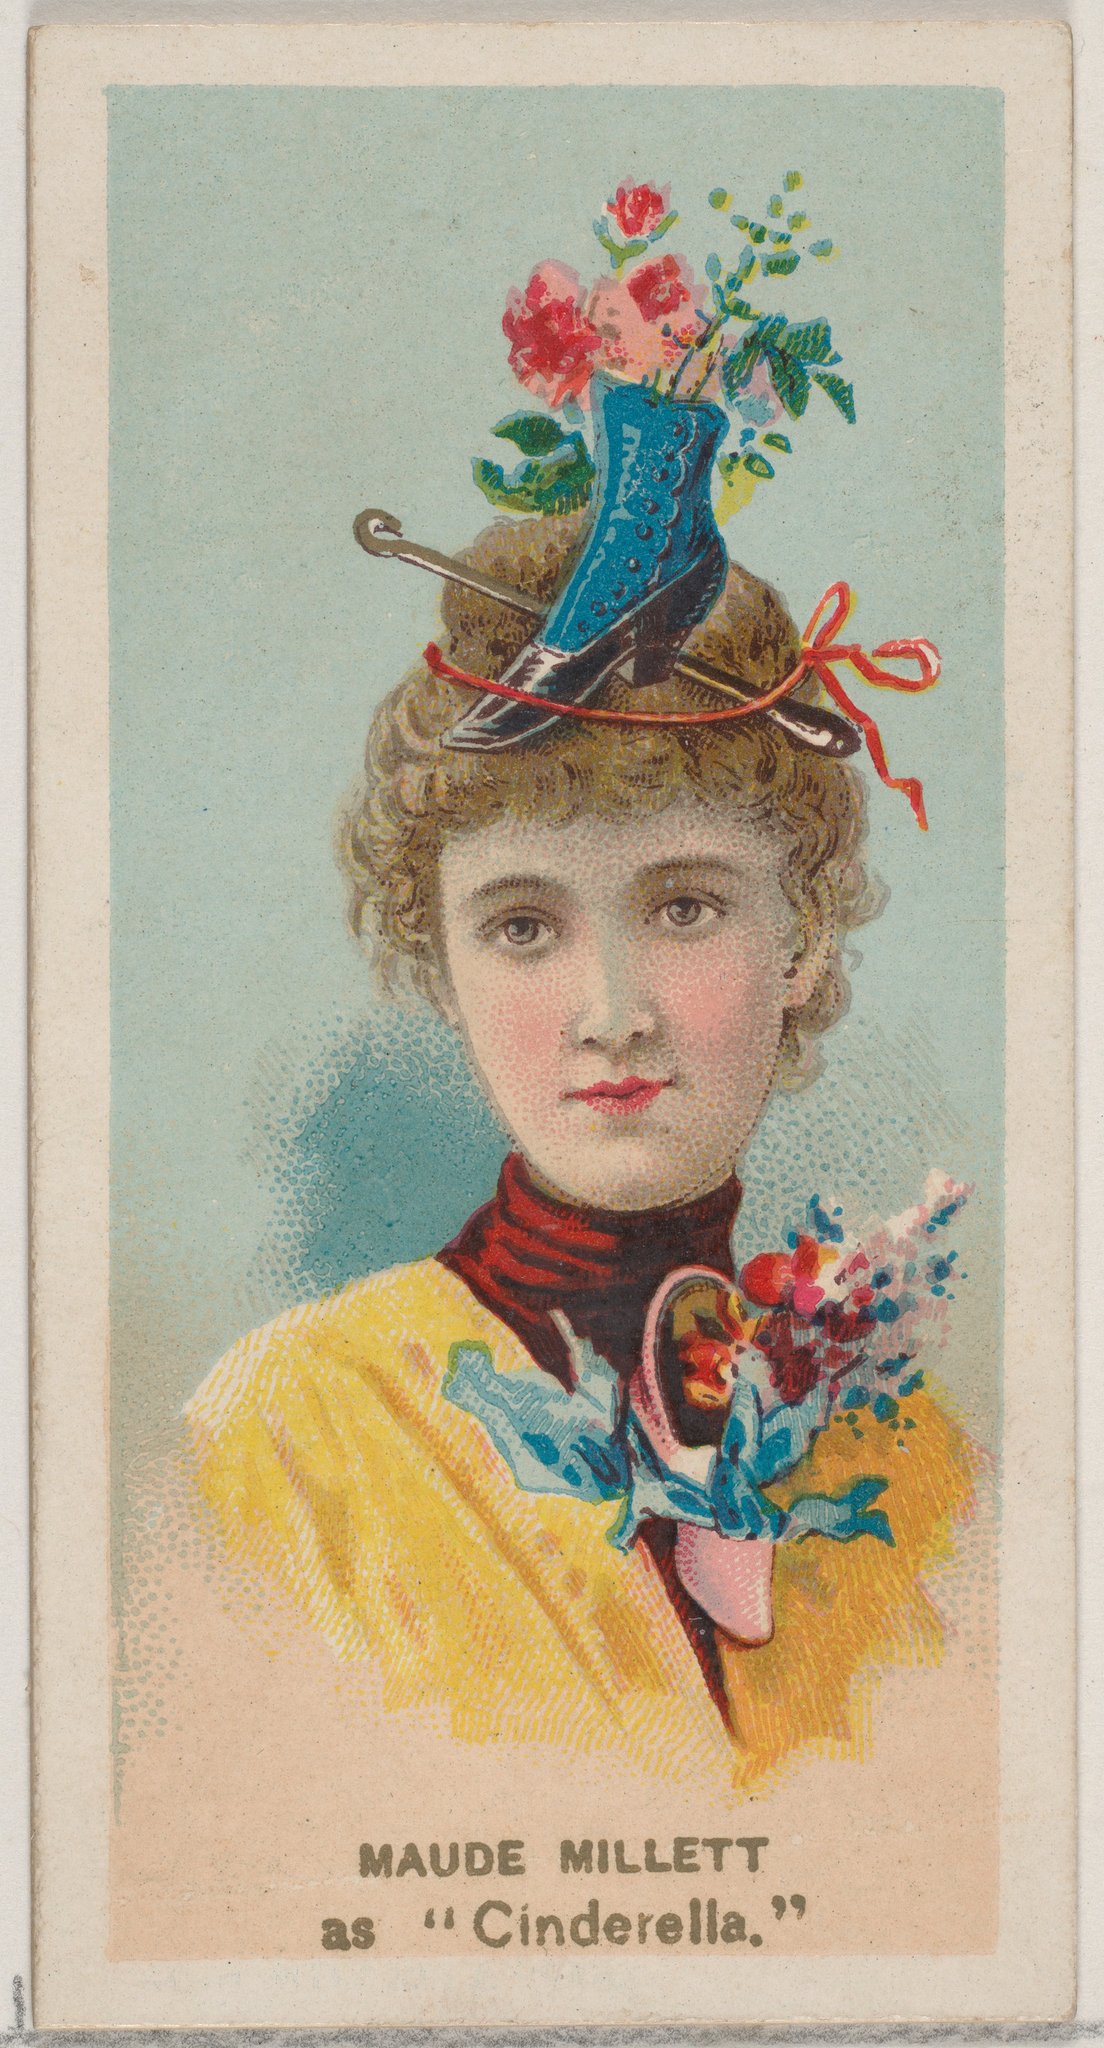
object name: print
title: Maude Millett as "Cinderella," from the series Fancy Dress Ball Costumes (N73) for Duke brand cigarettes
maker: w. duke, sons & co.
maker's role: publisher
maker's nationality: american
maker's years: 1870-1920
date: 1889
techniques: color lithograph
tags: shoes,women,actresses